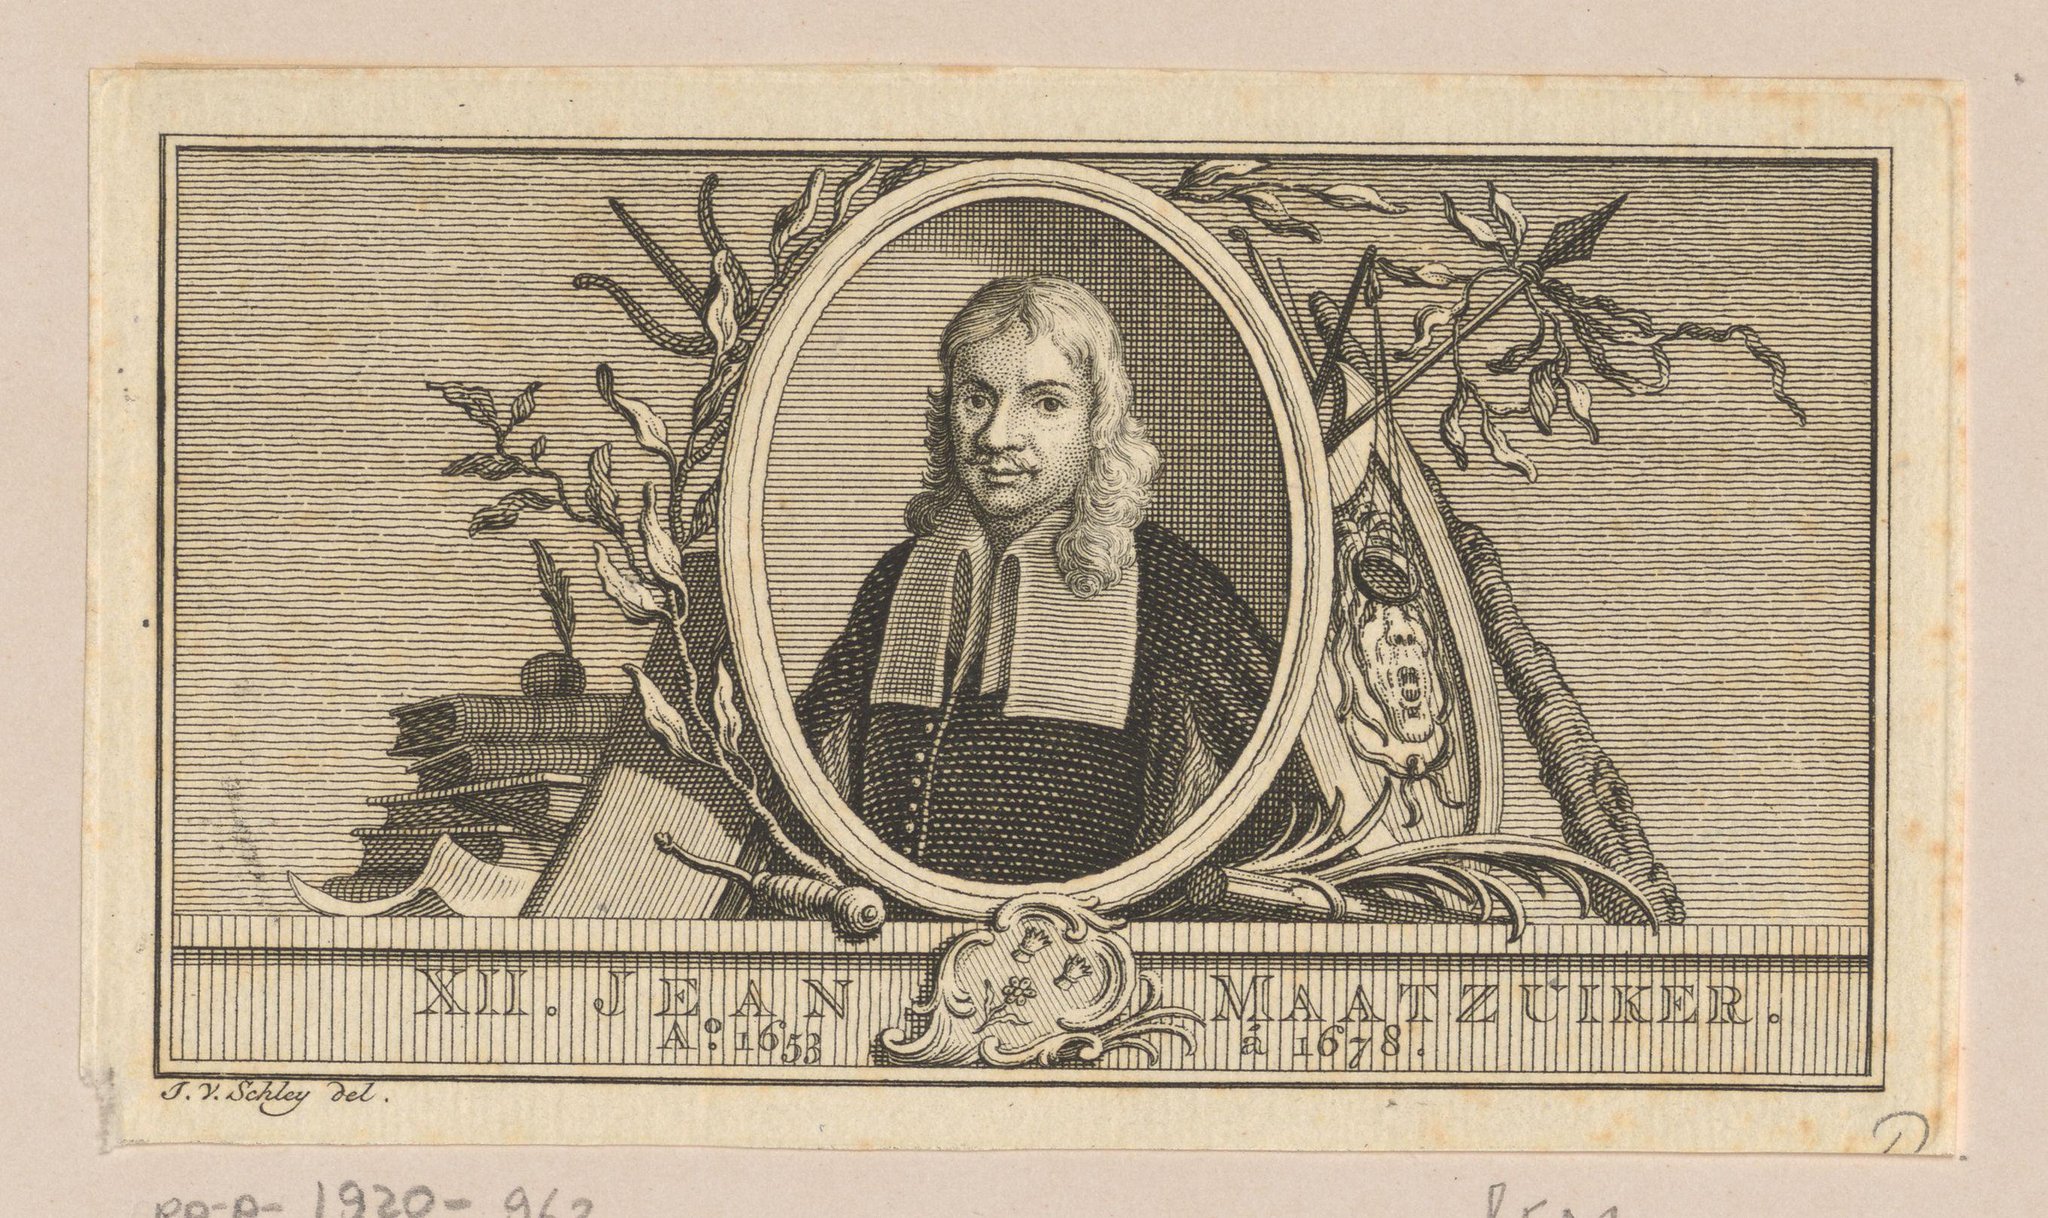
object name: print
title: Portret van Joan Maetsuycker op 47-jarige leeftijd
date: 1678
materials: paper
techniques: engraving, etching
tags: amsterdam, batavia, official; civil servant; functionary (in general), historical persons, lawyer, attorney at law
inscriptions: collector's mark: Lugt 964, collector's mark: Lugt 2228